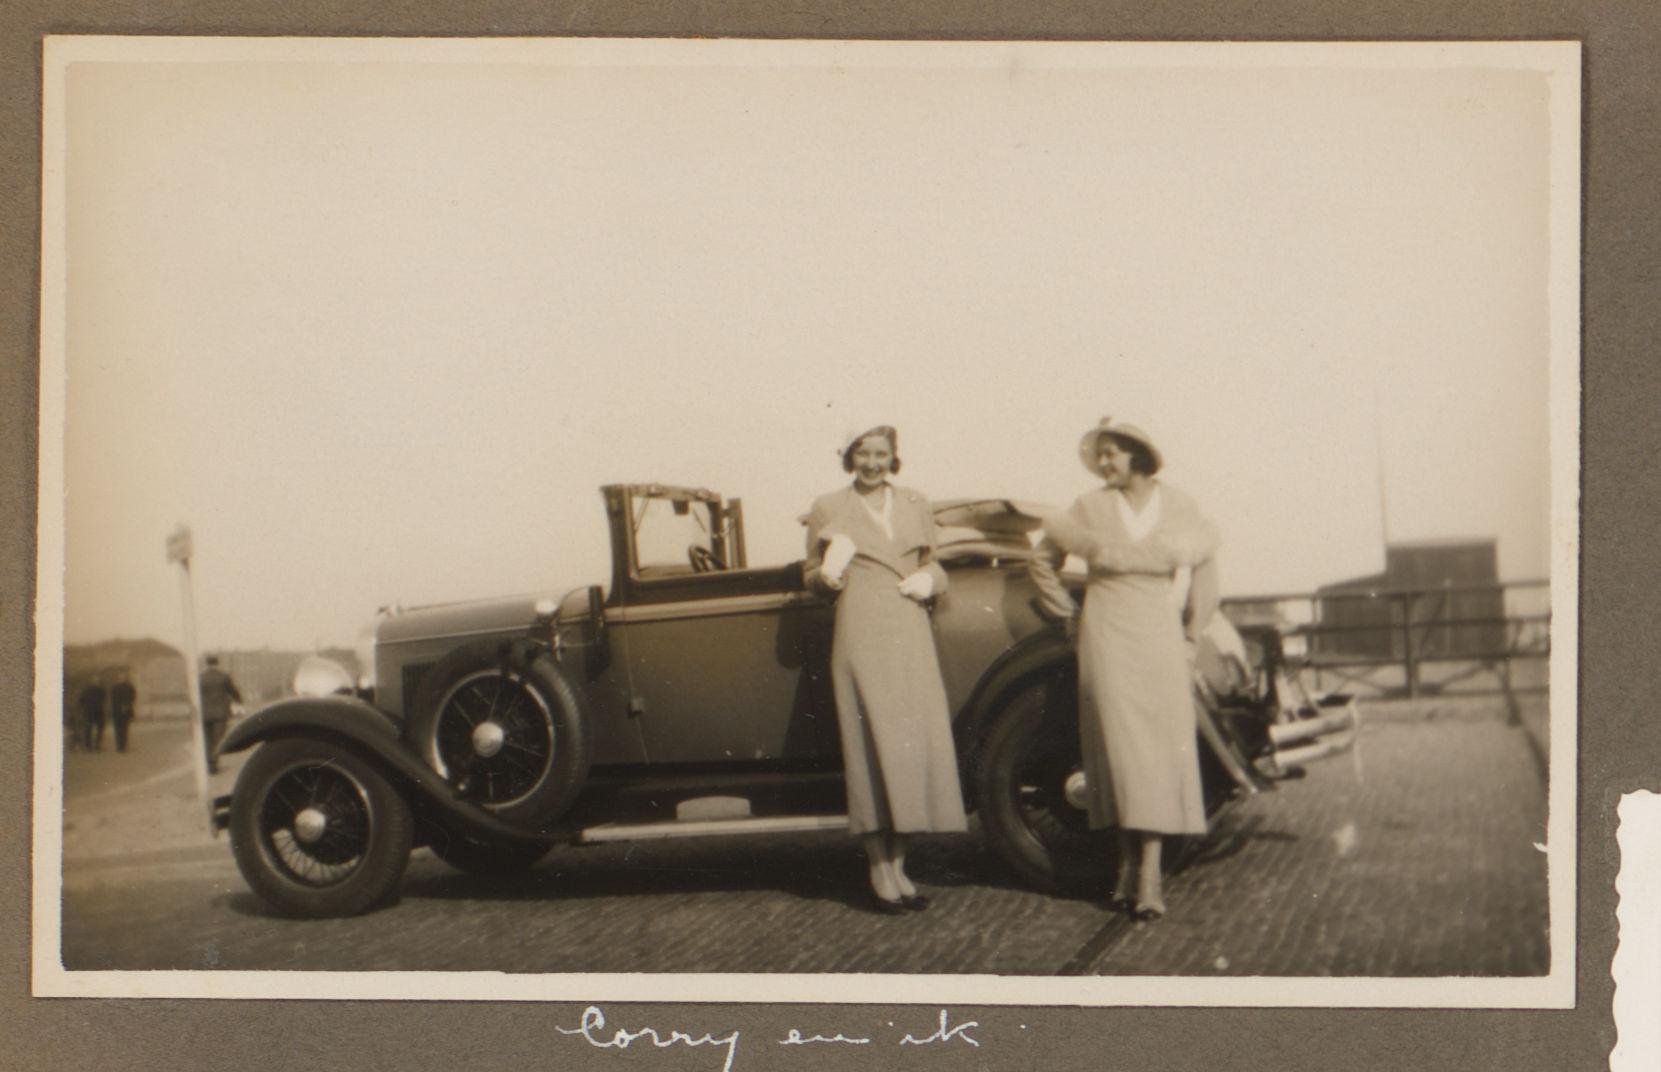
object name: photograph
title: Corry Goelst en Wilhelmina van Zijll de Jong bij een auto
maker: Anonymous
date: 1932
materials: paper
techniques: gelatin silver print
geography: belgium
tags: wilhelmina van zijll de jong, historical persons - bb - woman, automobile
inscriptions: inscription: ‘Corry en ik’